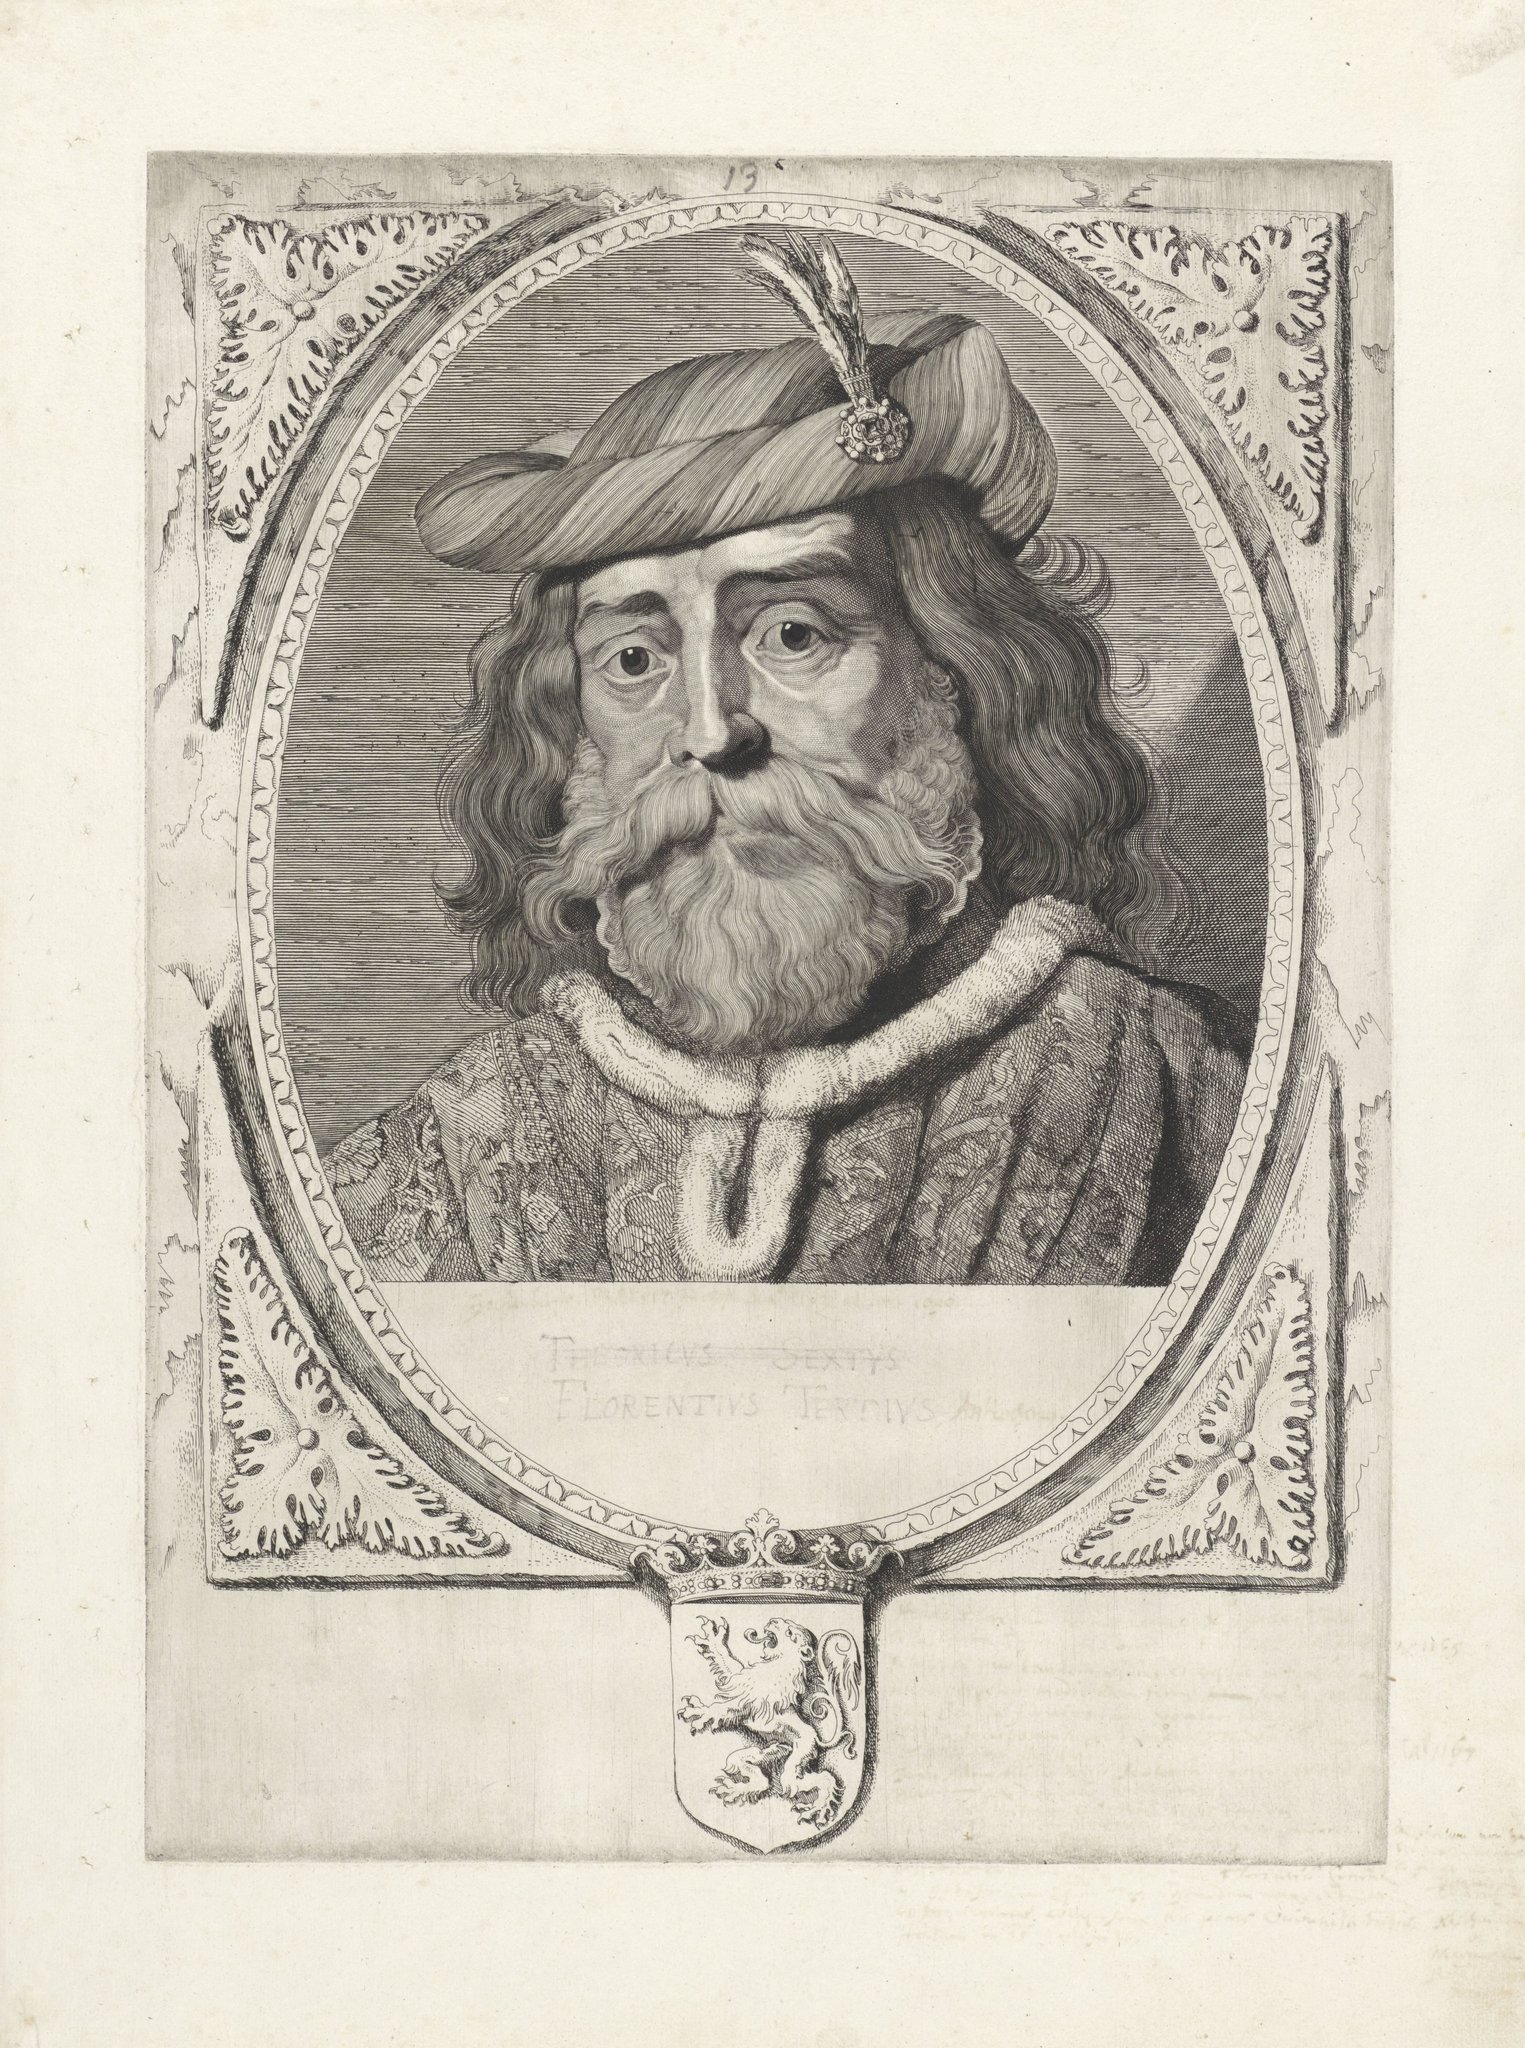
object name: print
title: Portret van Floris III, graaf van Holland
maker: cornelis visscher (ii)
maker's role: draughtsman, painter, print maker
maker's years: 1628-1658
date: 1650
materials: paper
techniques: engraving, etching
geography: haarlem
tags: head-gear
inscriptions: collector's mark: Lugt 240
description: Proefdruk van de dertiende prent uit de serie 'Graven en gravinnen van Holland, Zeeland en West-Friesland', bestaande uit 38 prenten.